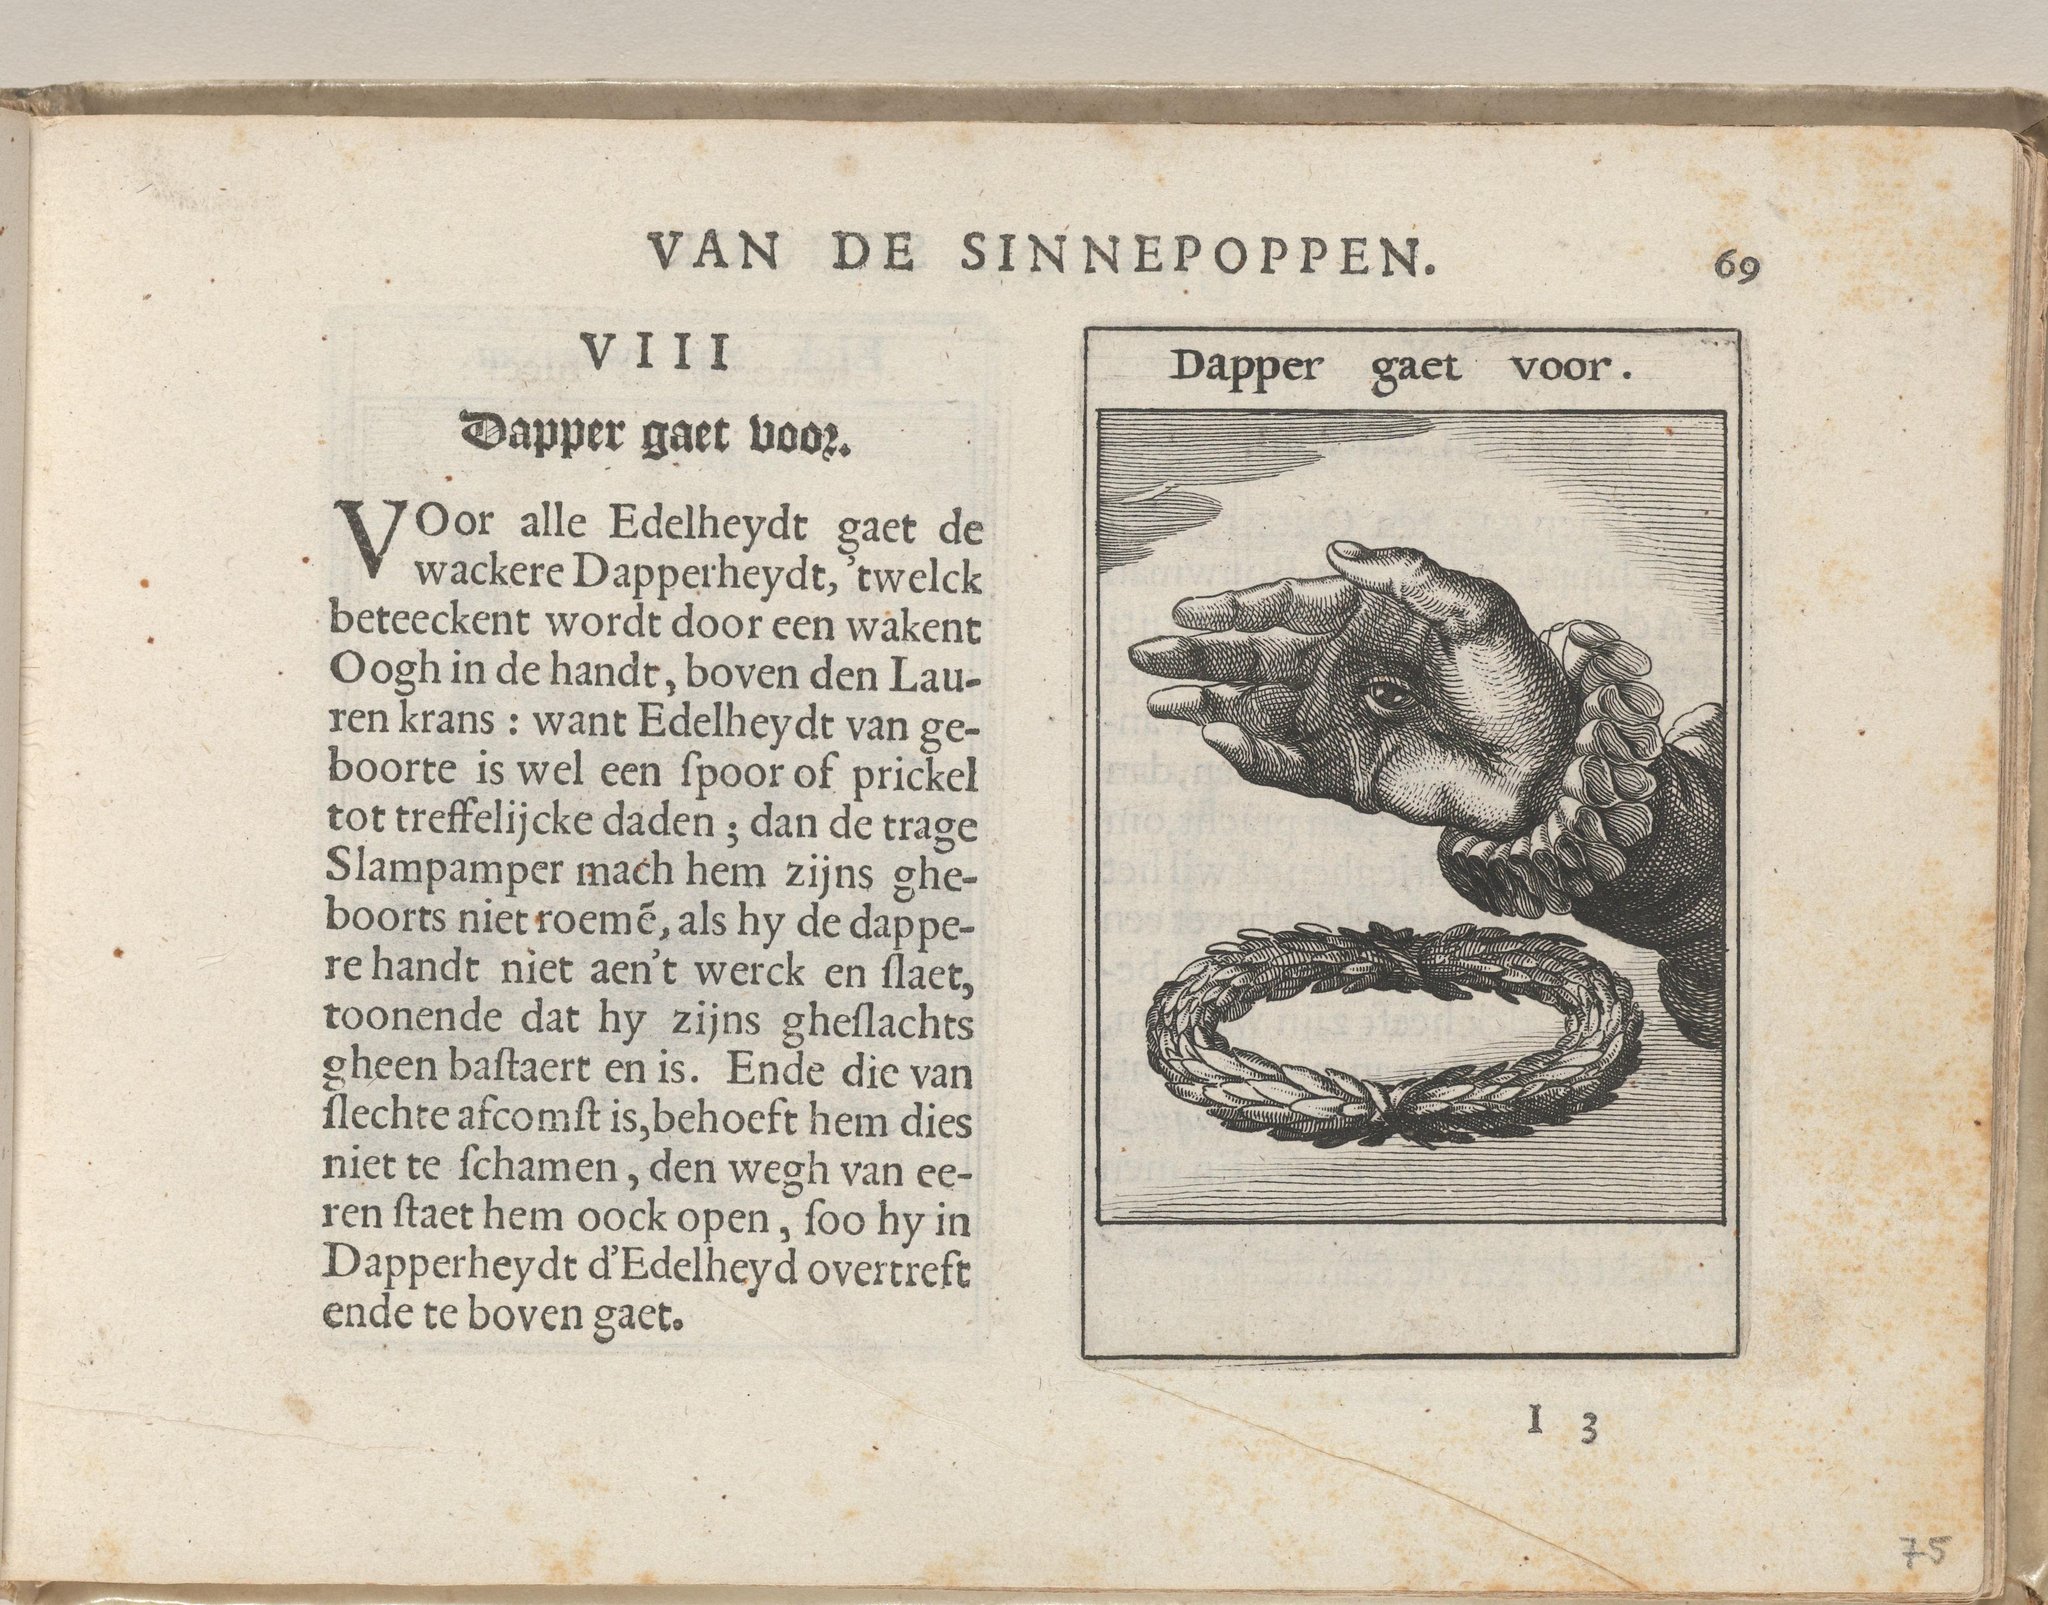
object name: album leaf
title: VIII Dapper gaet voor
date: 1614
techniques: engraving, printing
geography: amsterdam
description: VIII Dapper gaet voor. Tweede schok. Onderdeel van 'Sinnepoppen', R. Visscher, 1614.